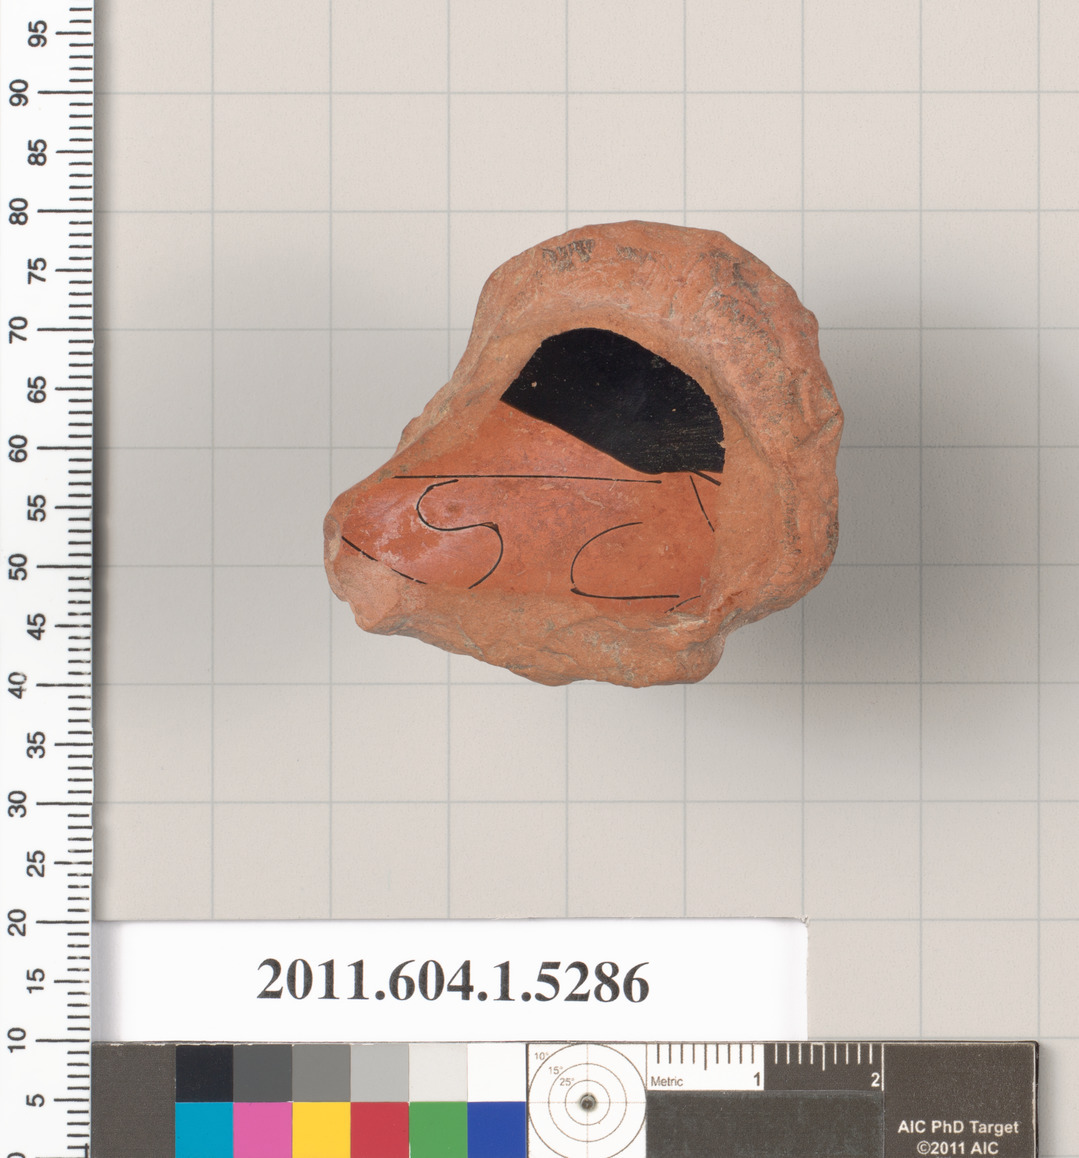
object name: kylix fragment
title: Terracotta fragment of a kylix (drinking cup)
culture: greek, attic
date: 475-451 BCE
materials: terracotta